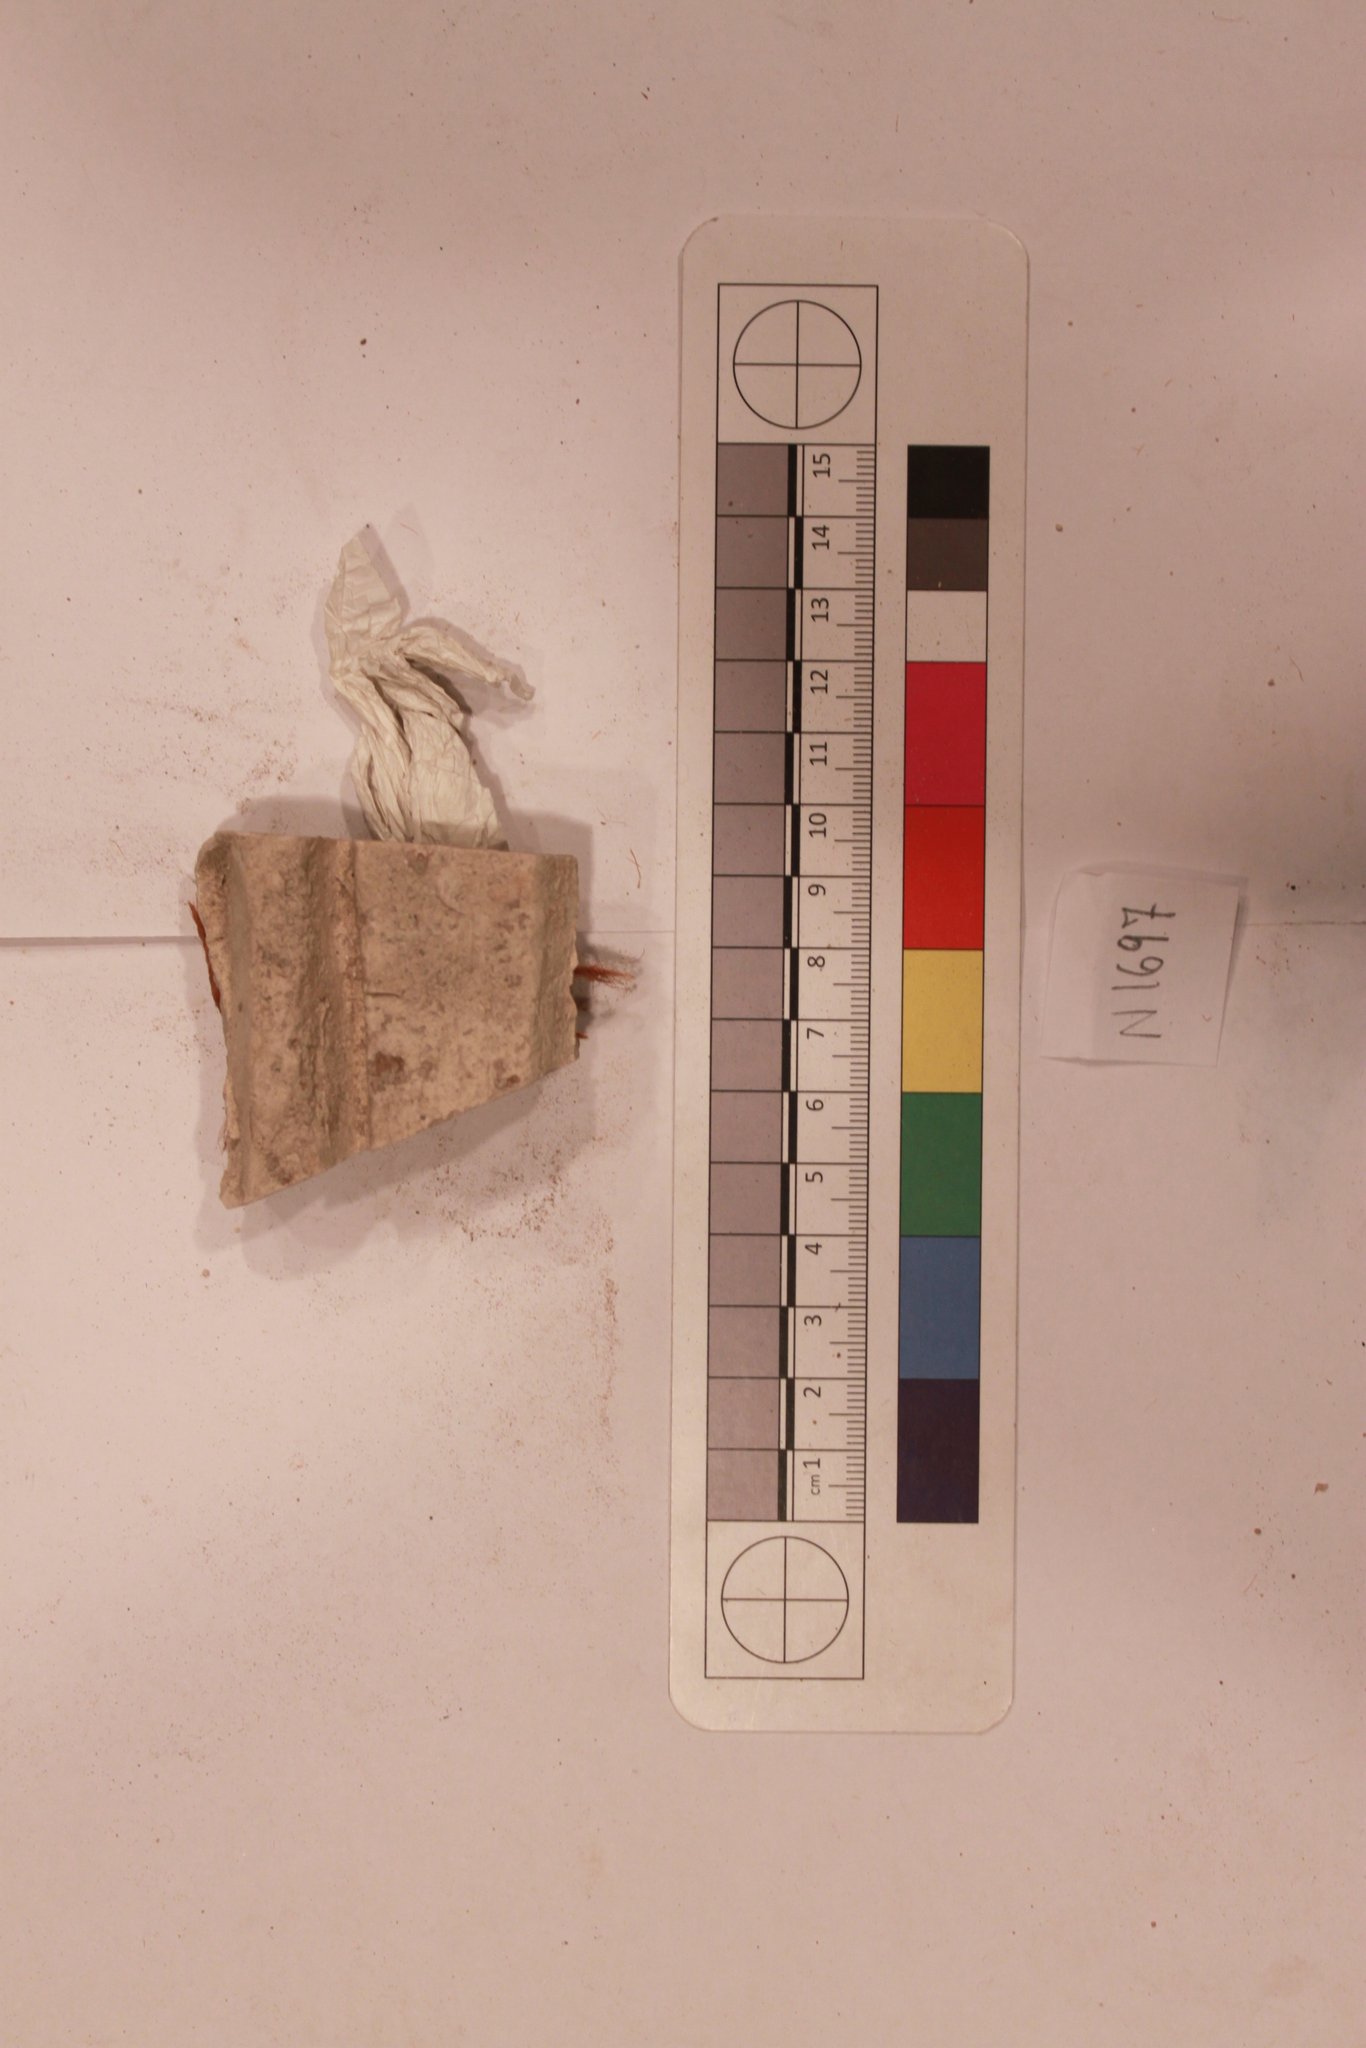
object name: fragment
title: Stucco Fragment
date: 701-1200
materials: gypsum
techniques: carving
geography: iran